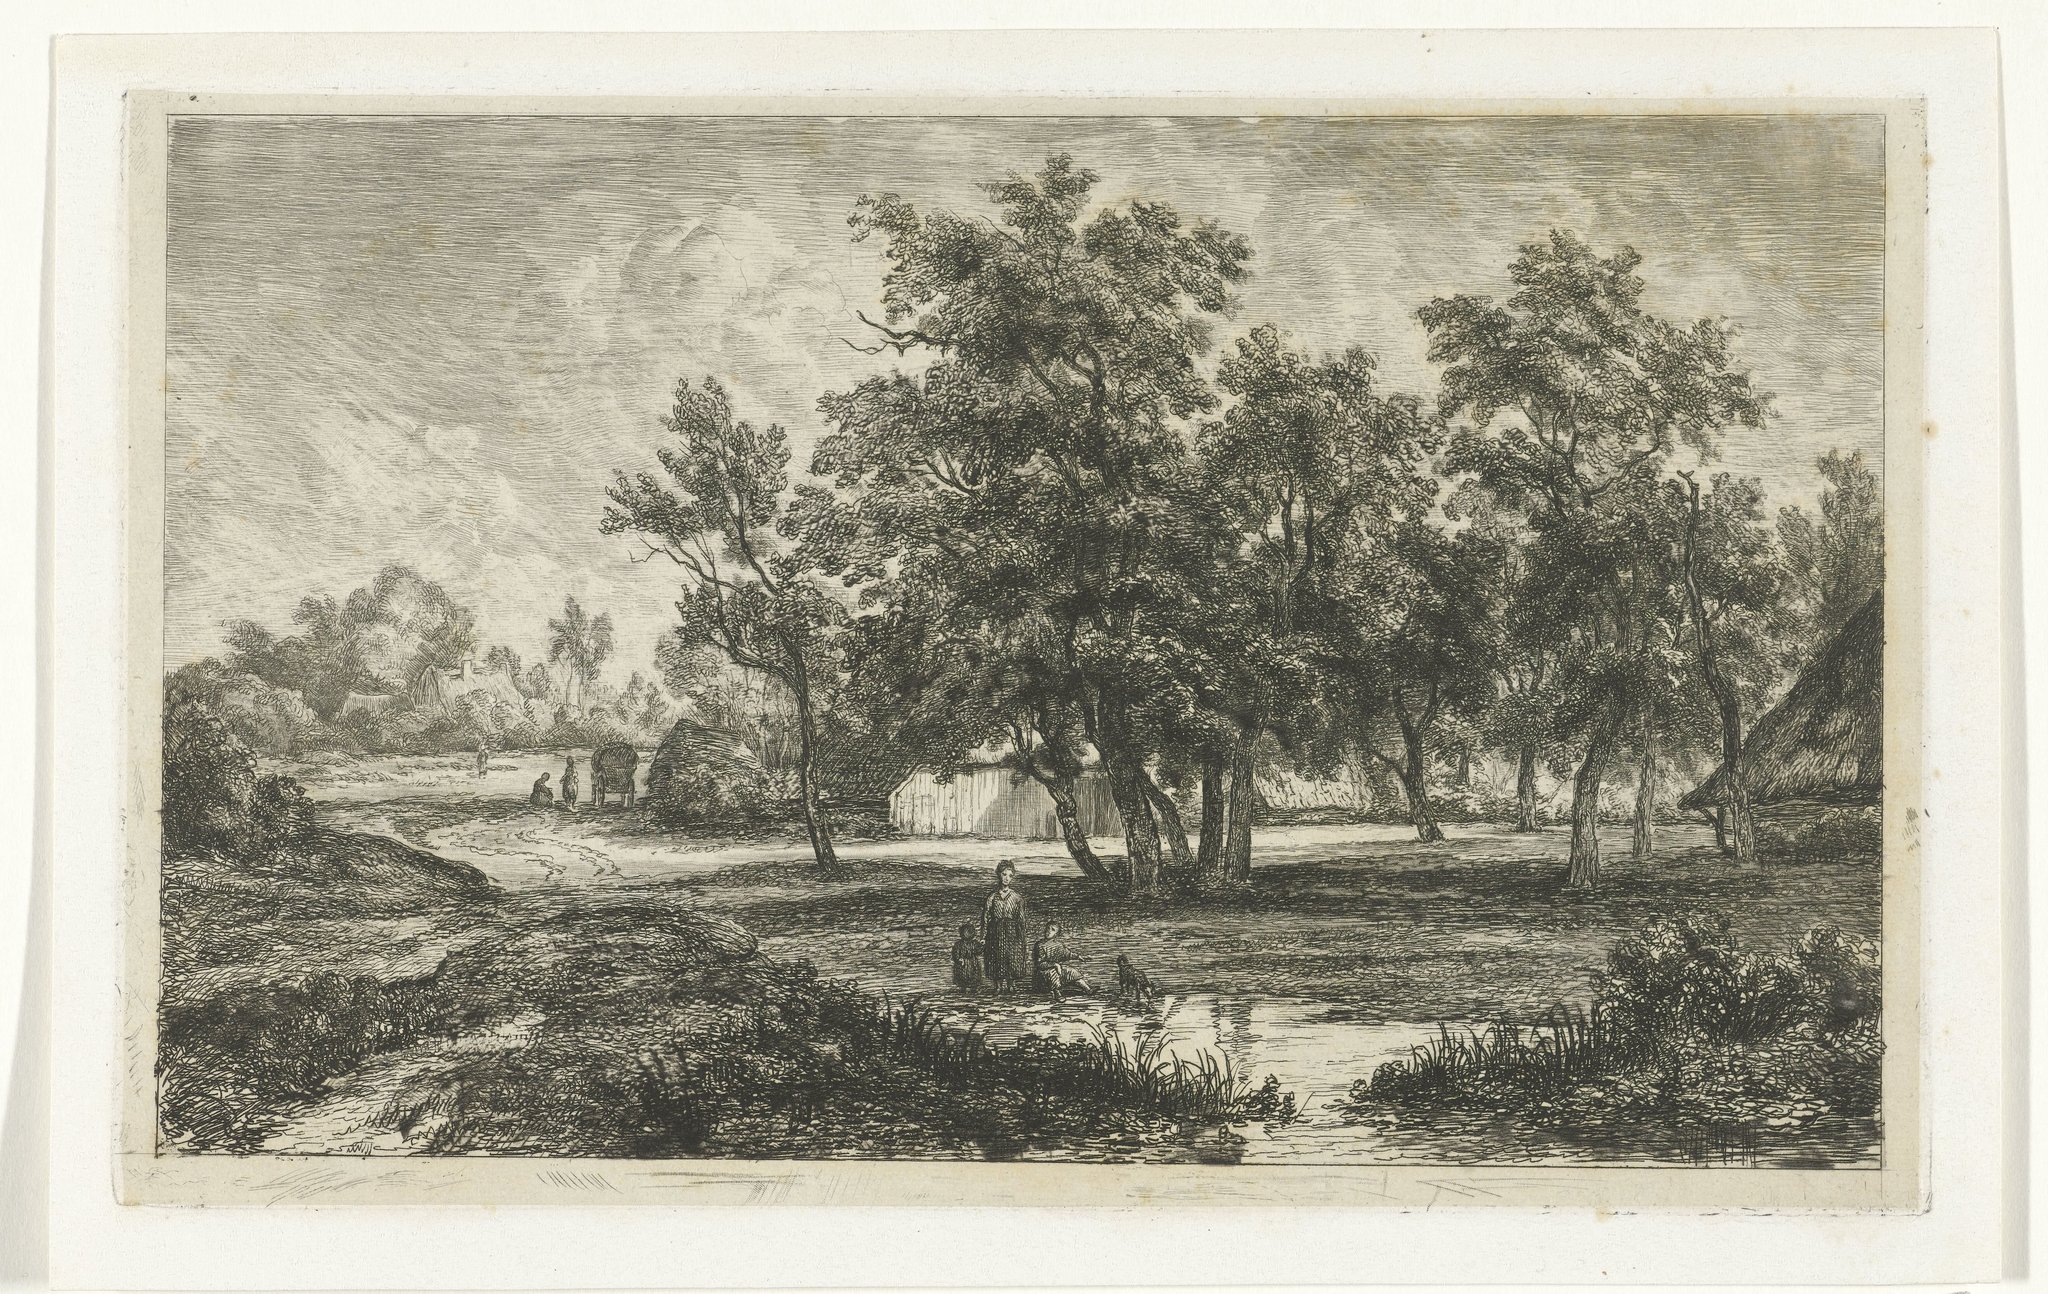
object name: print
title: Landschap met boerderij tussen de bomen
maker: christiaan immerzeel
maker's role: print maker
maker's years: 1808-1886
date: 1818-1886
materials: paper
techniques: etching, roulette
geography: netherlands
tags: landscapes (+ landscape with figures, staffage), farm or solitary house in landscape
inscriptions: collector's mark: Lugt 2228, collector's mark: Lugt 2760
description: Landschap met drie figuren en een hond bij een waterplas. Daarachter ligt een boerderij tussen de bomen. Links een weg met figuren en een kar.